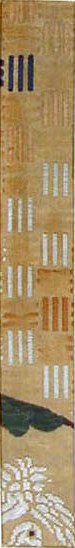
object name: piece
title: Textile with Partial Pattern of Crane Roundel and Squares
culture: japanese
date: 1615-1868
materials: silk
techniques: brocade, weave